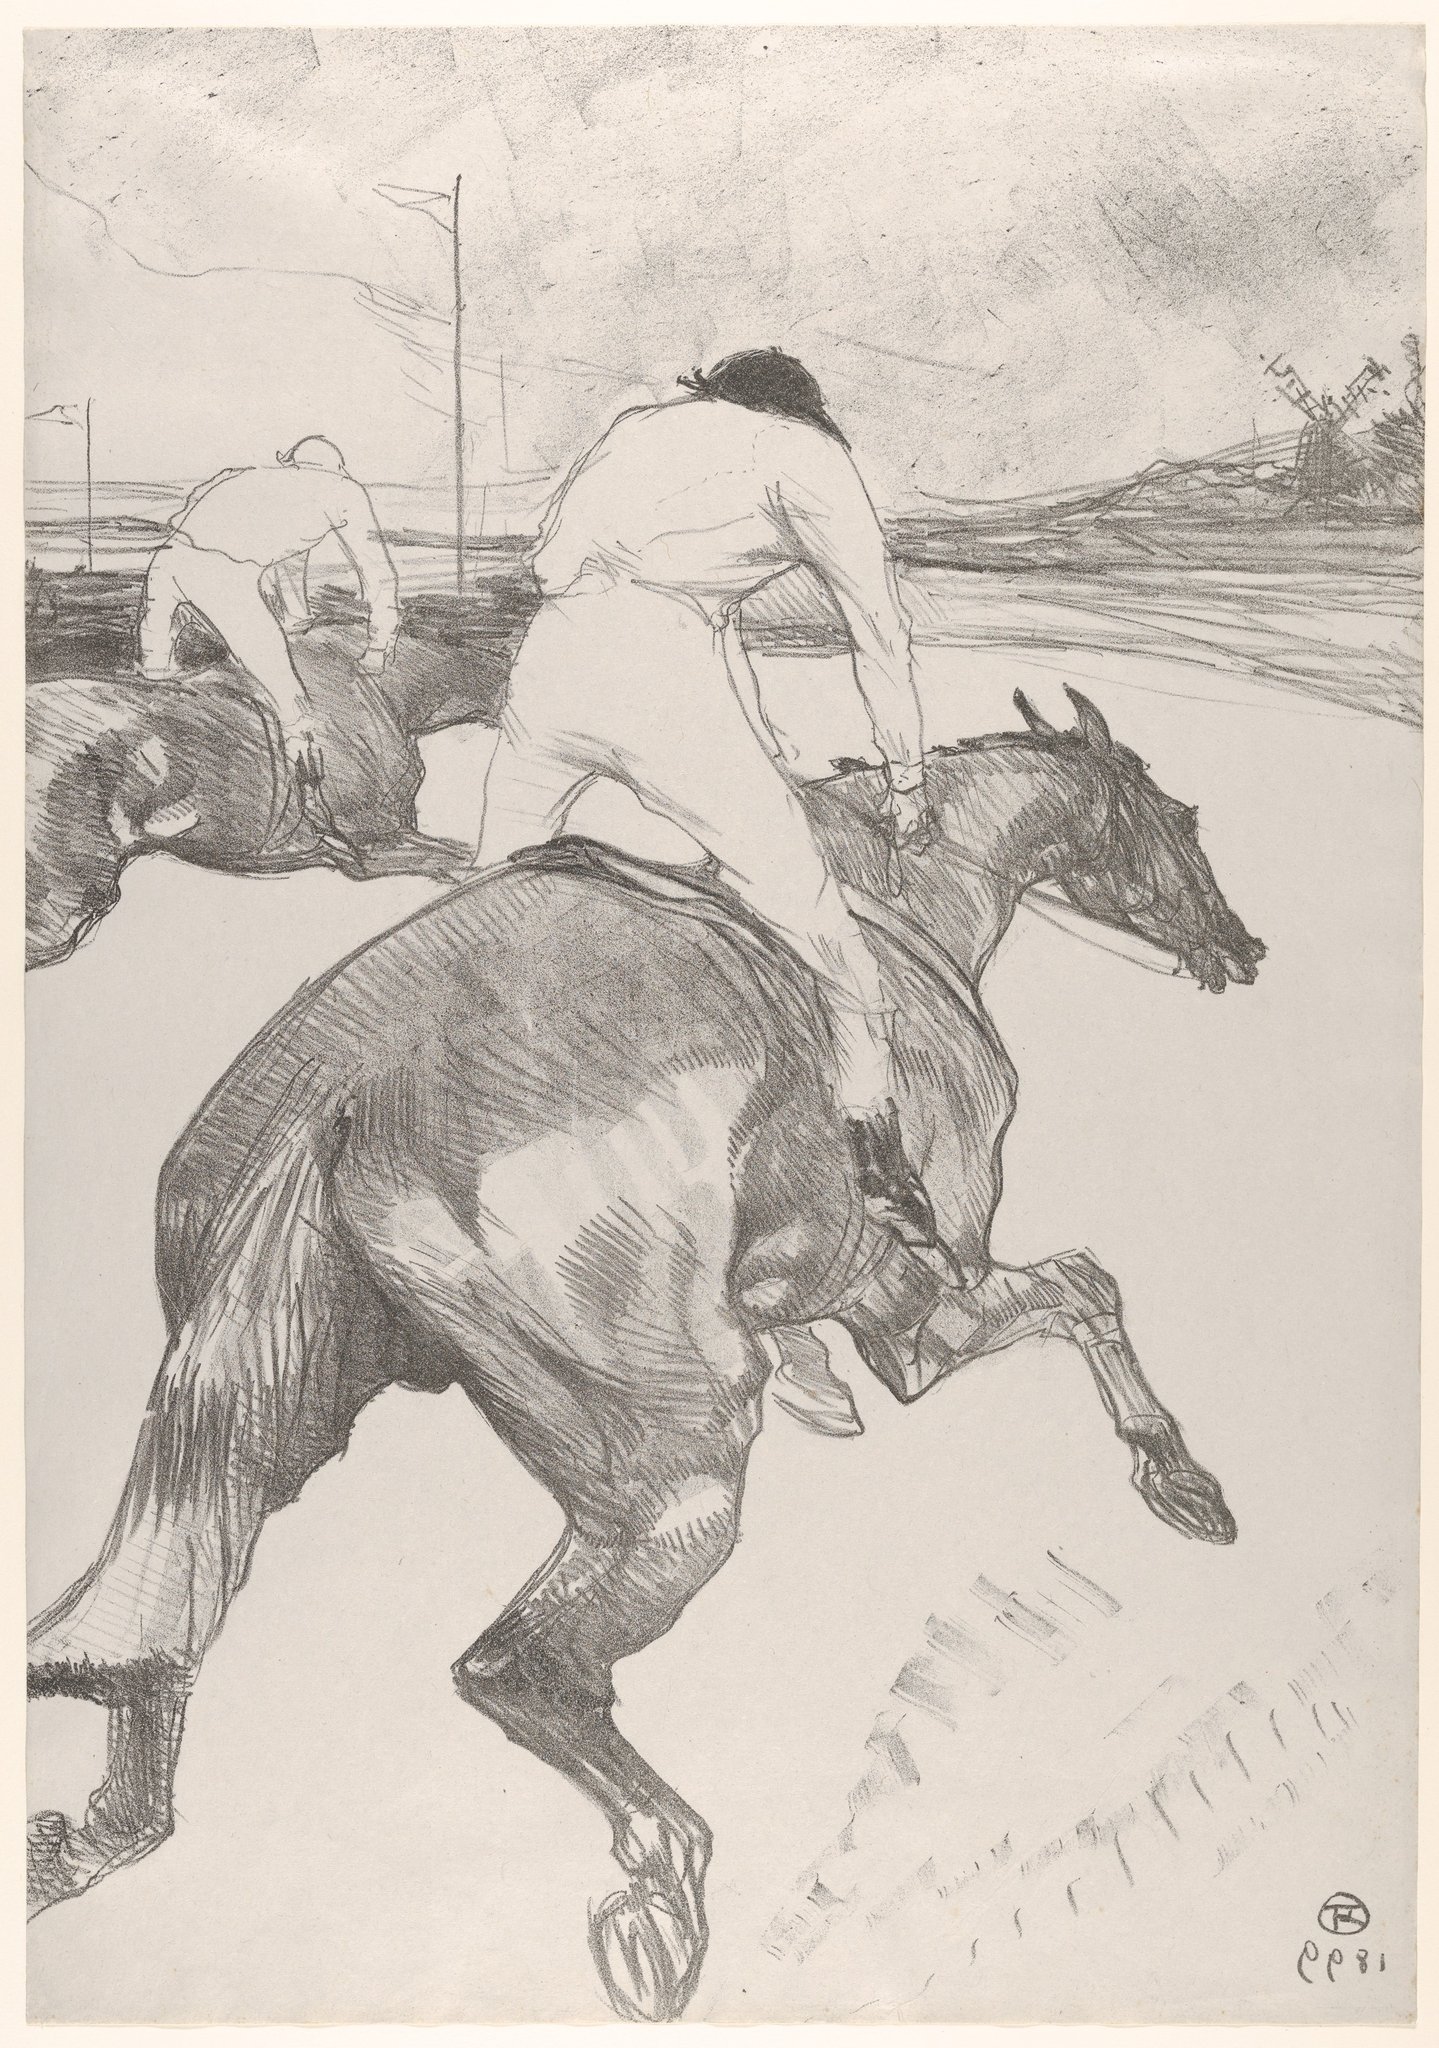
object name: print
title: The Jockey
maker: henri de toulouse-lautrec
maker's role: artist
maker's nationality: french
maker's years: 1864-1901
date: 1899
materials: paper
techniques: lithograph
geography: france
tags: horses,jockeys